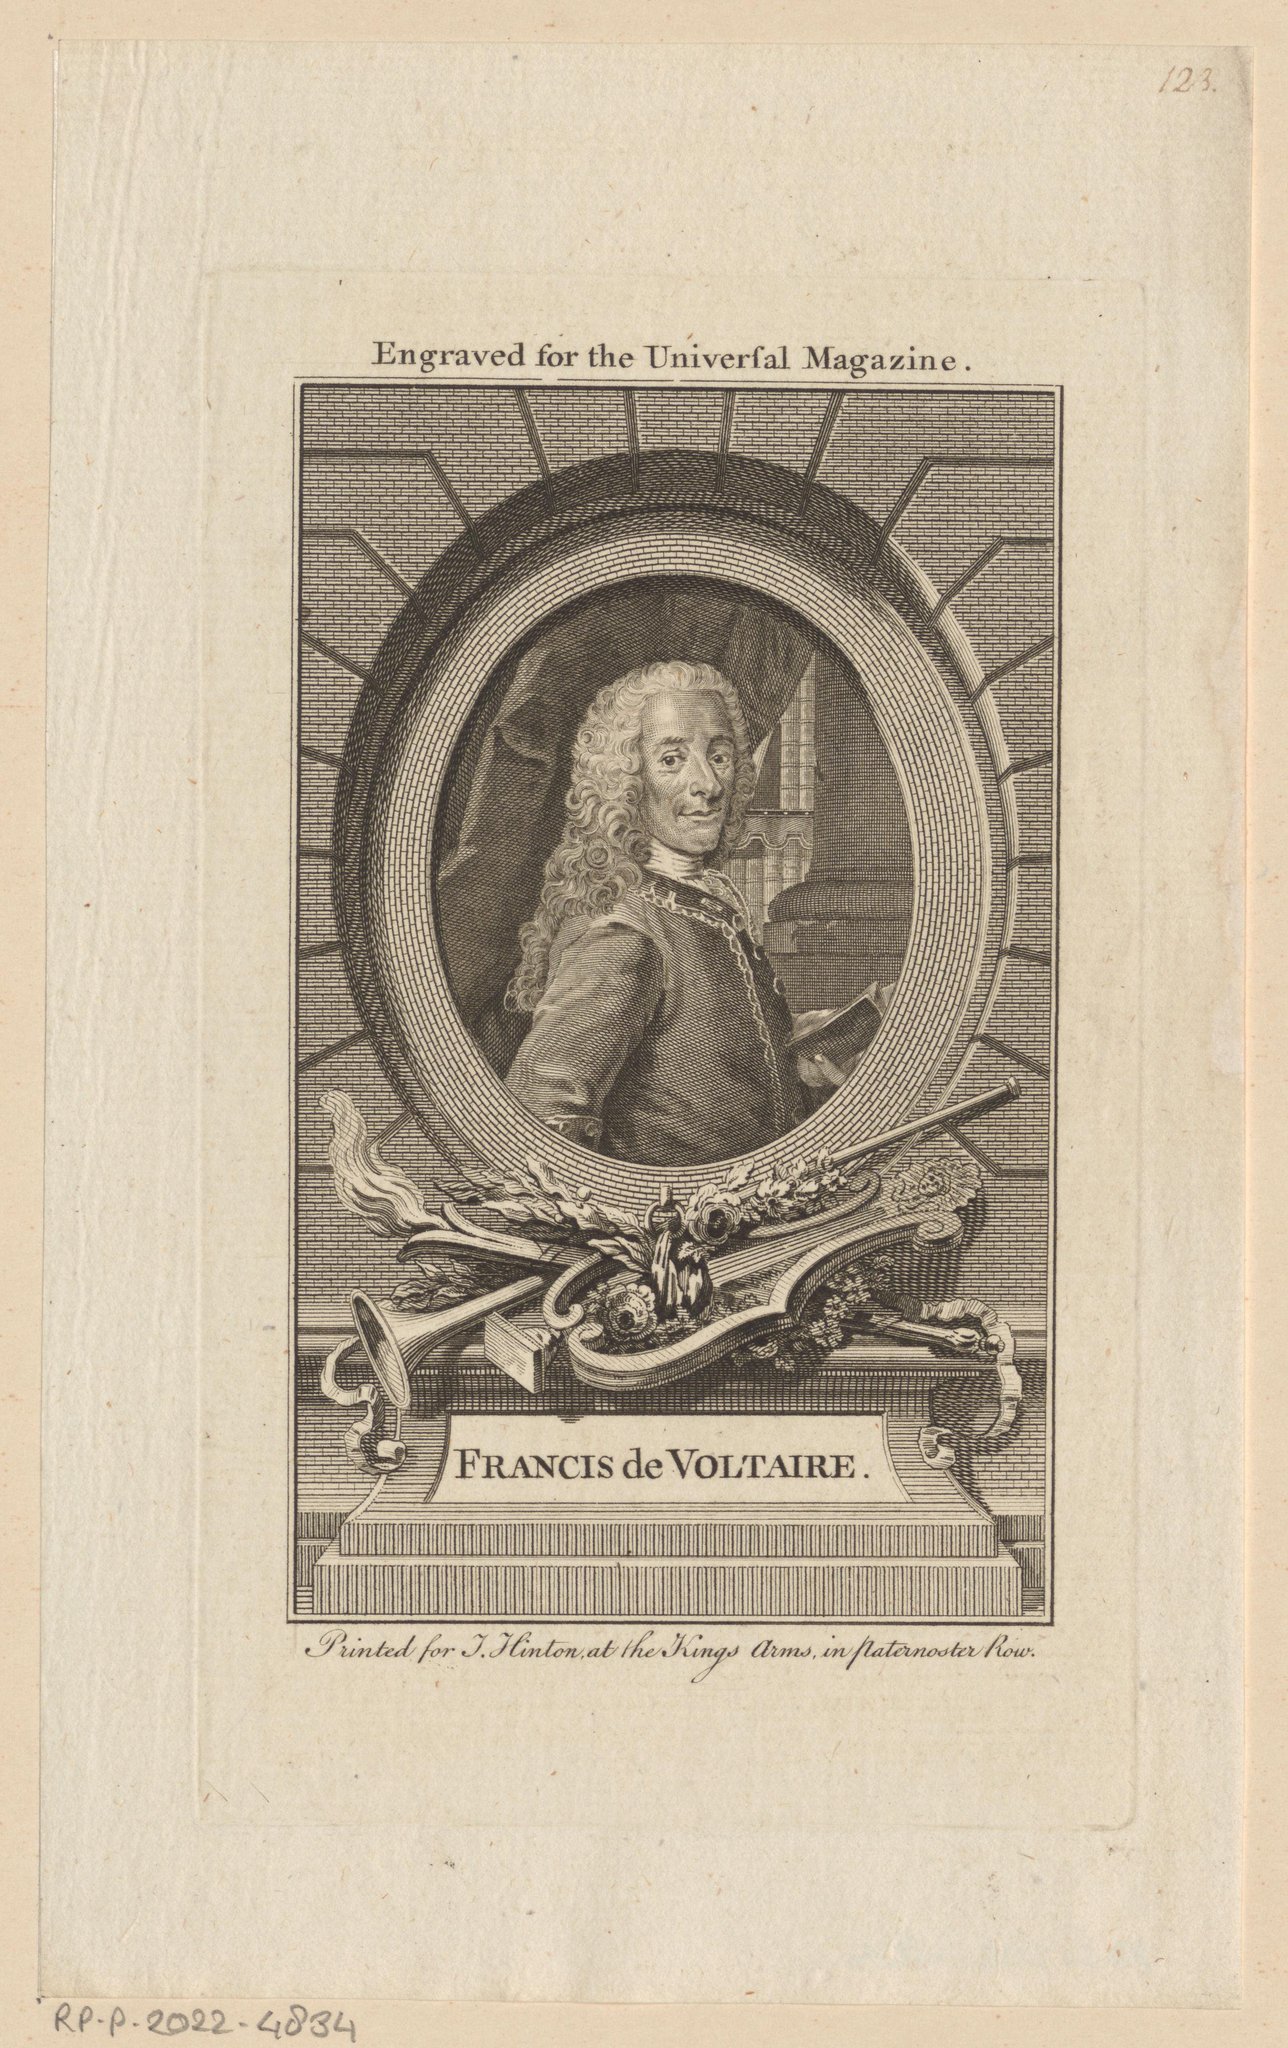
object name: print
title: Portret van Voltaire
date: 1777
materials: paper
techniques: engraving, etching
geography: london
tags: paris, voltaire, historical persons, portrait of a writer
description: Prent waarschijnlijk uit: The Universal Magazine of Knowledge and Pleasure (1777), nr. 60, p. 112-113.